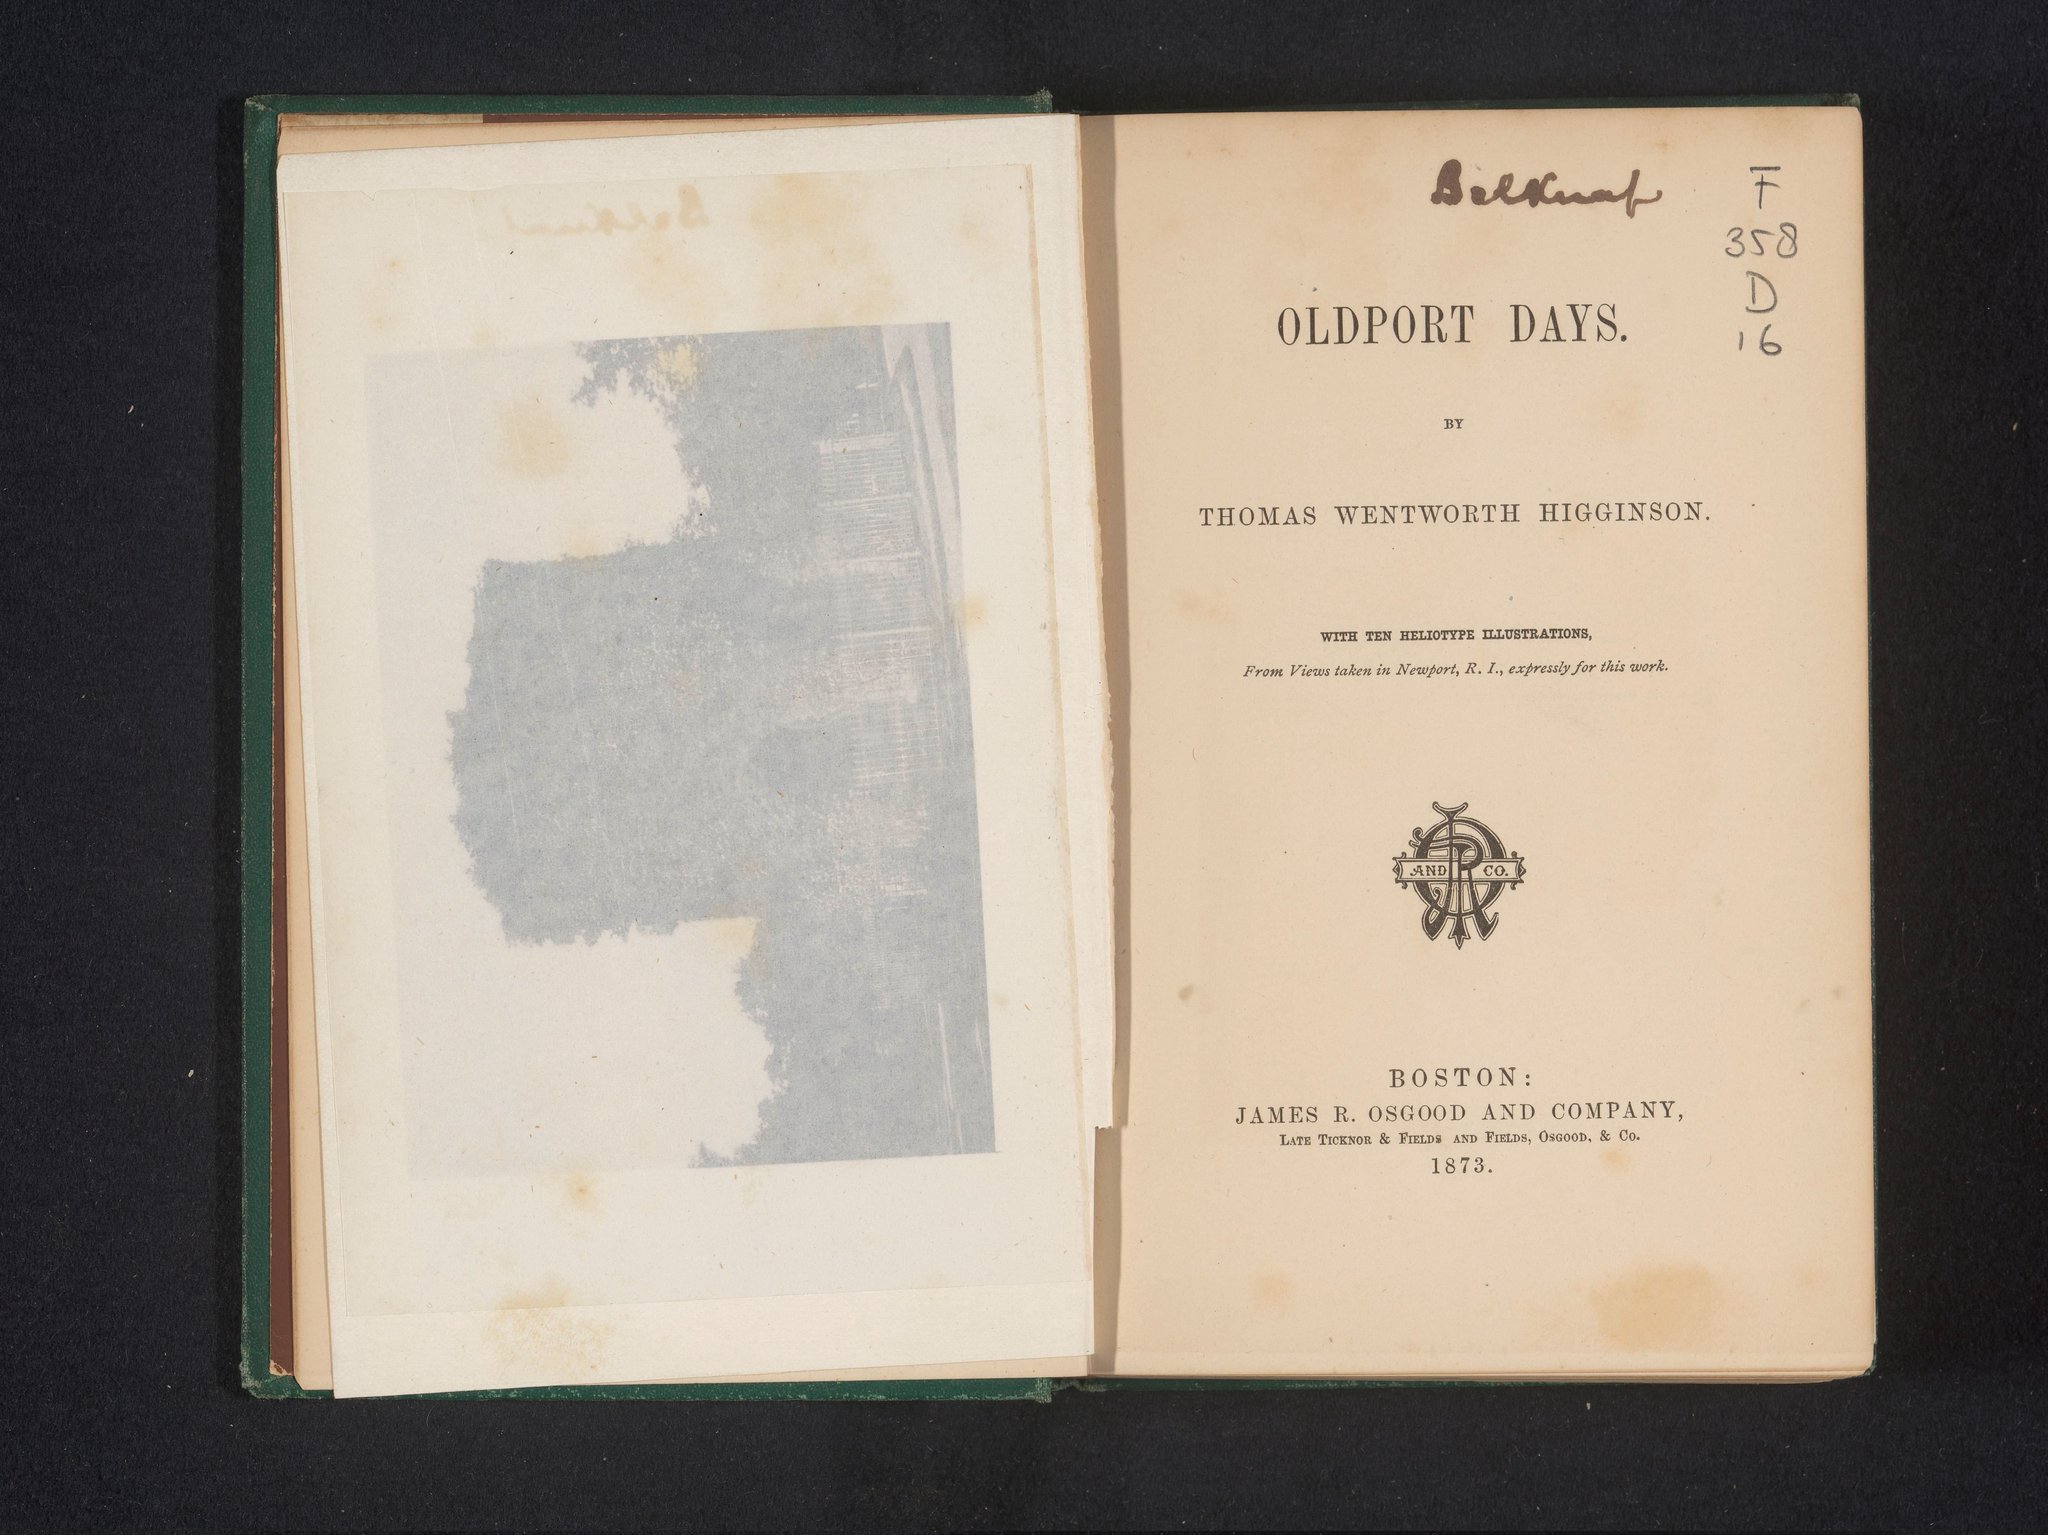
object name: book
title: Oldport days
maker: thomas wentworth higginson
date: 1873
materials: cardboard, linen, paper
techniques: photograph, printing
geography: boston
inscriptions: inscription: ‘To Franny, "Ge[...]r" September 1873’, inscription: ‘Belknap 101.’